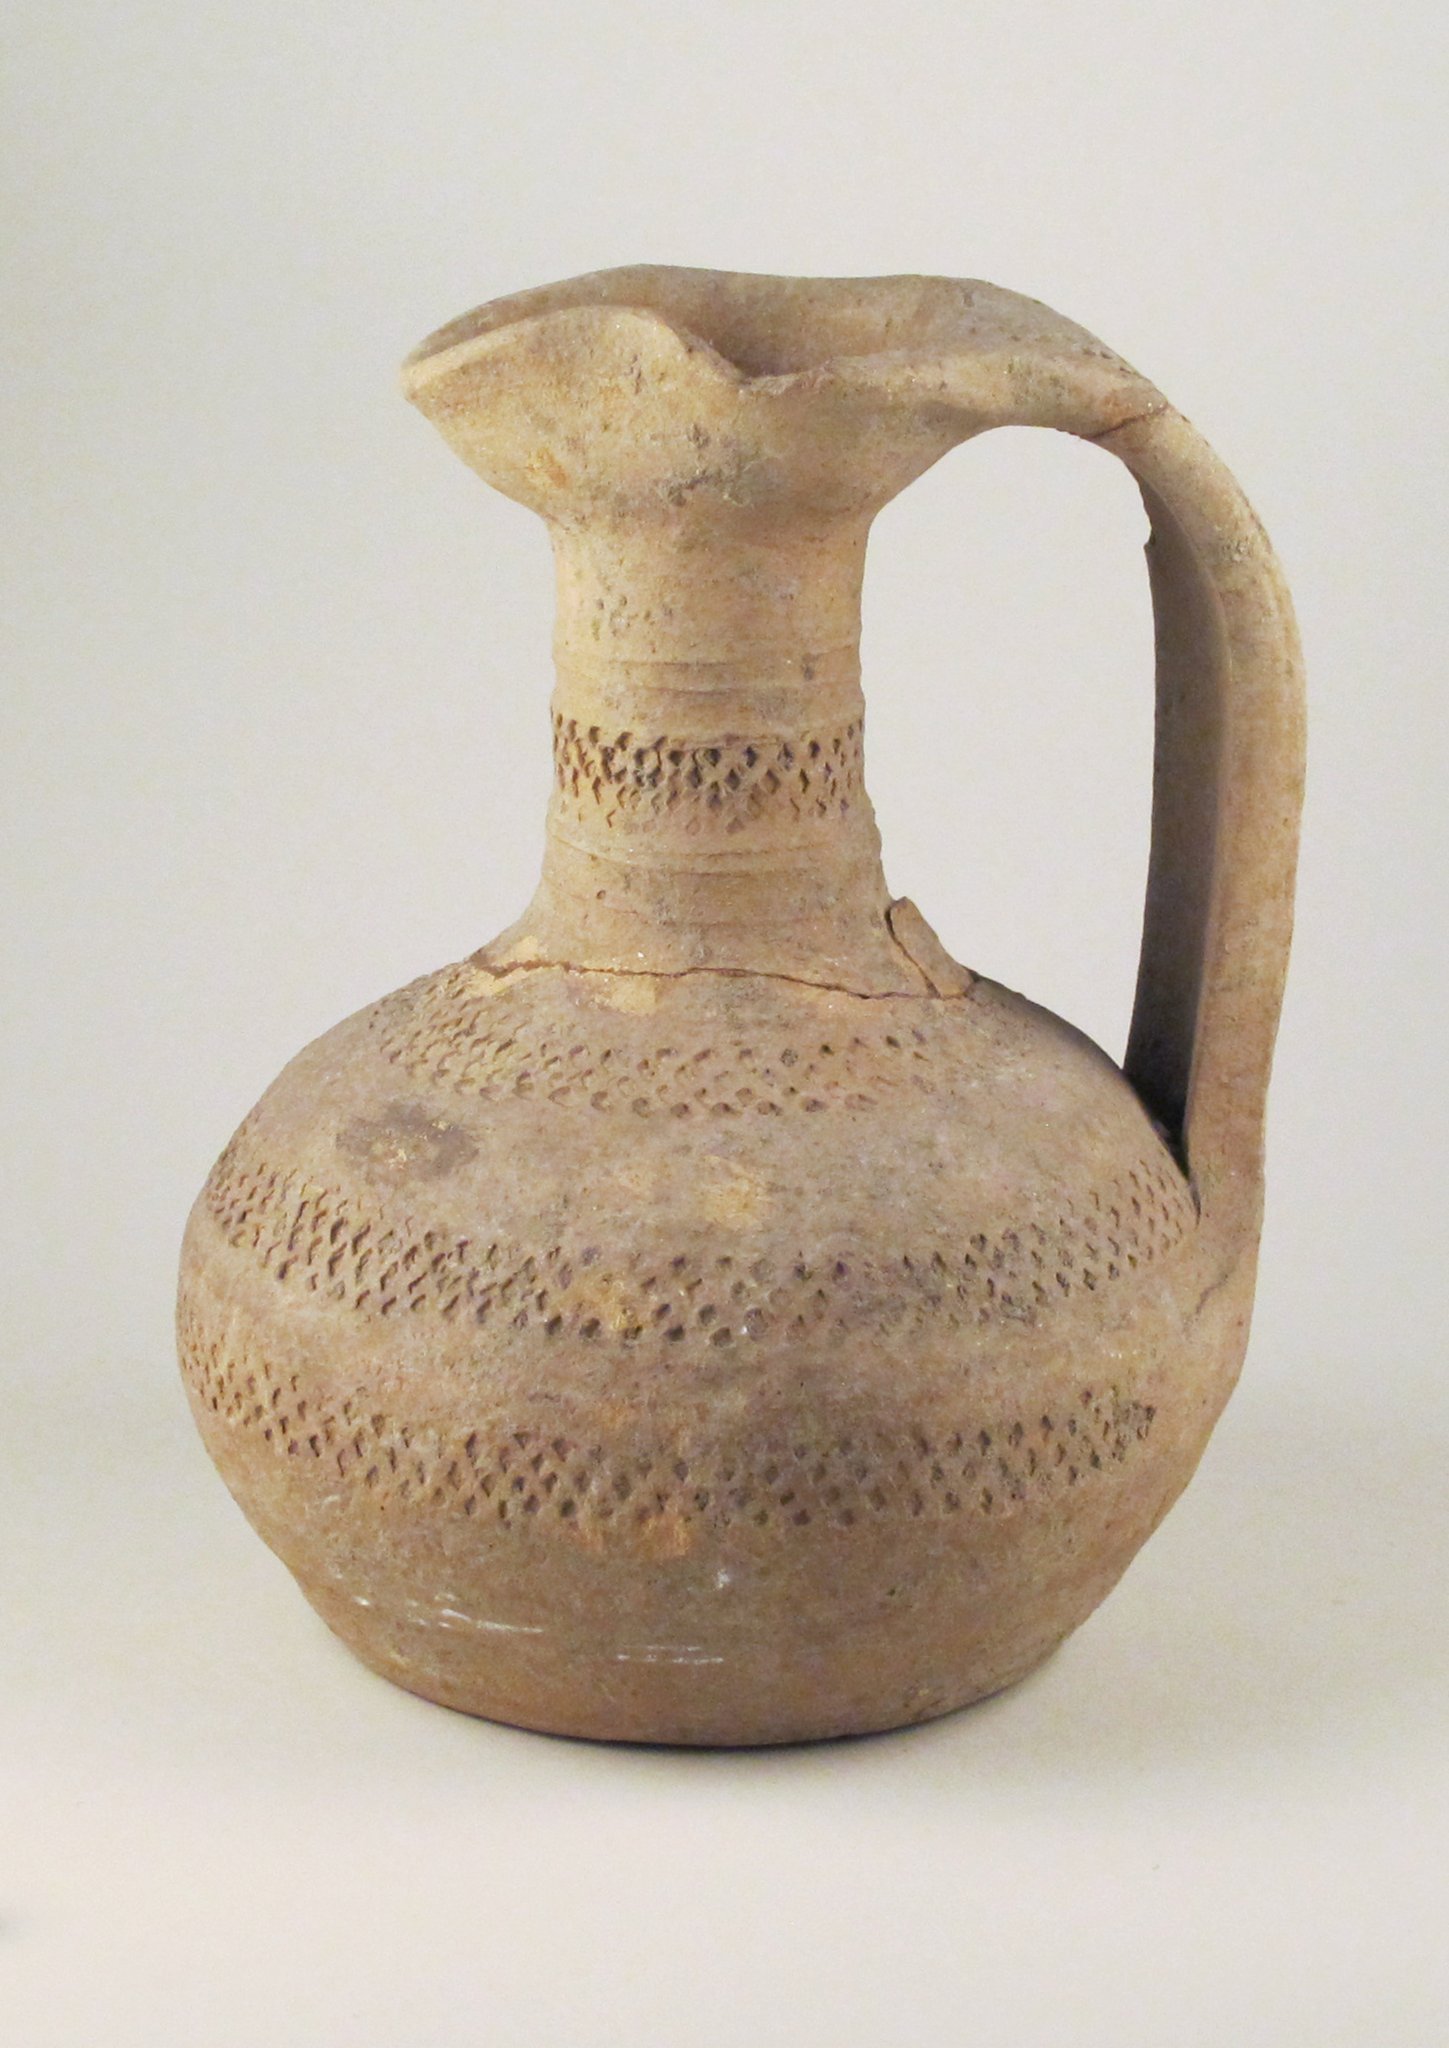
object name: jug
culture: roman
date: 670 BCE-330 CE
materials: terracotta